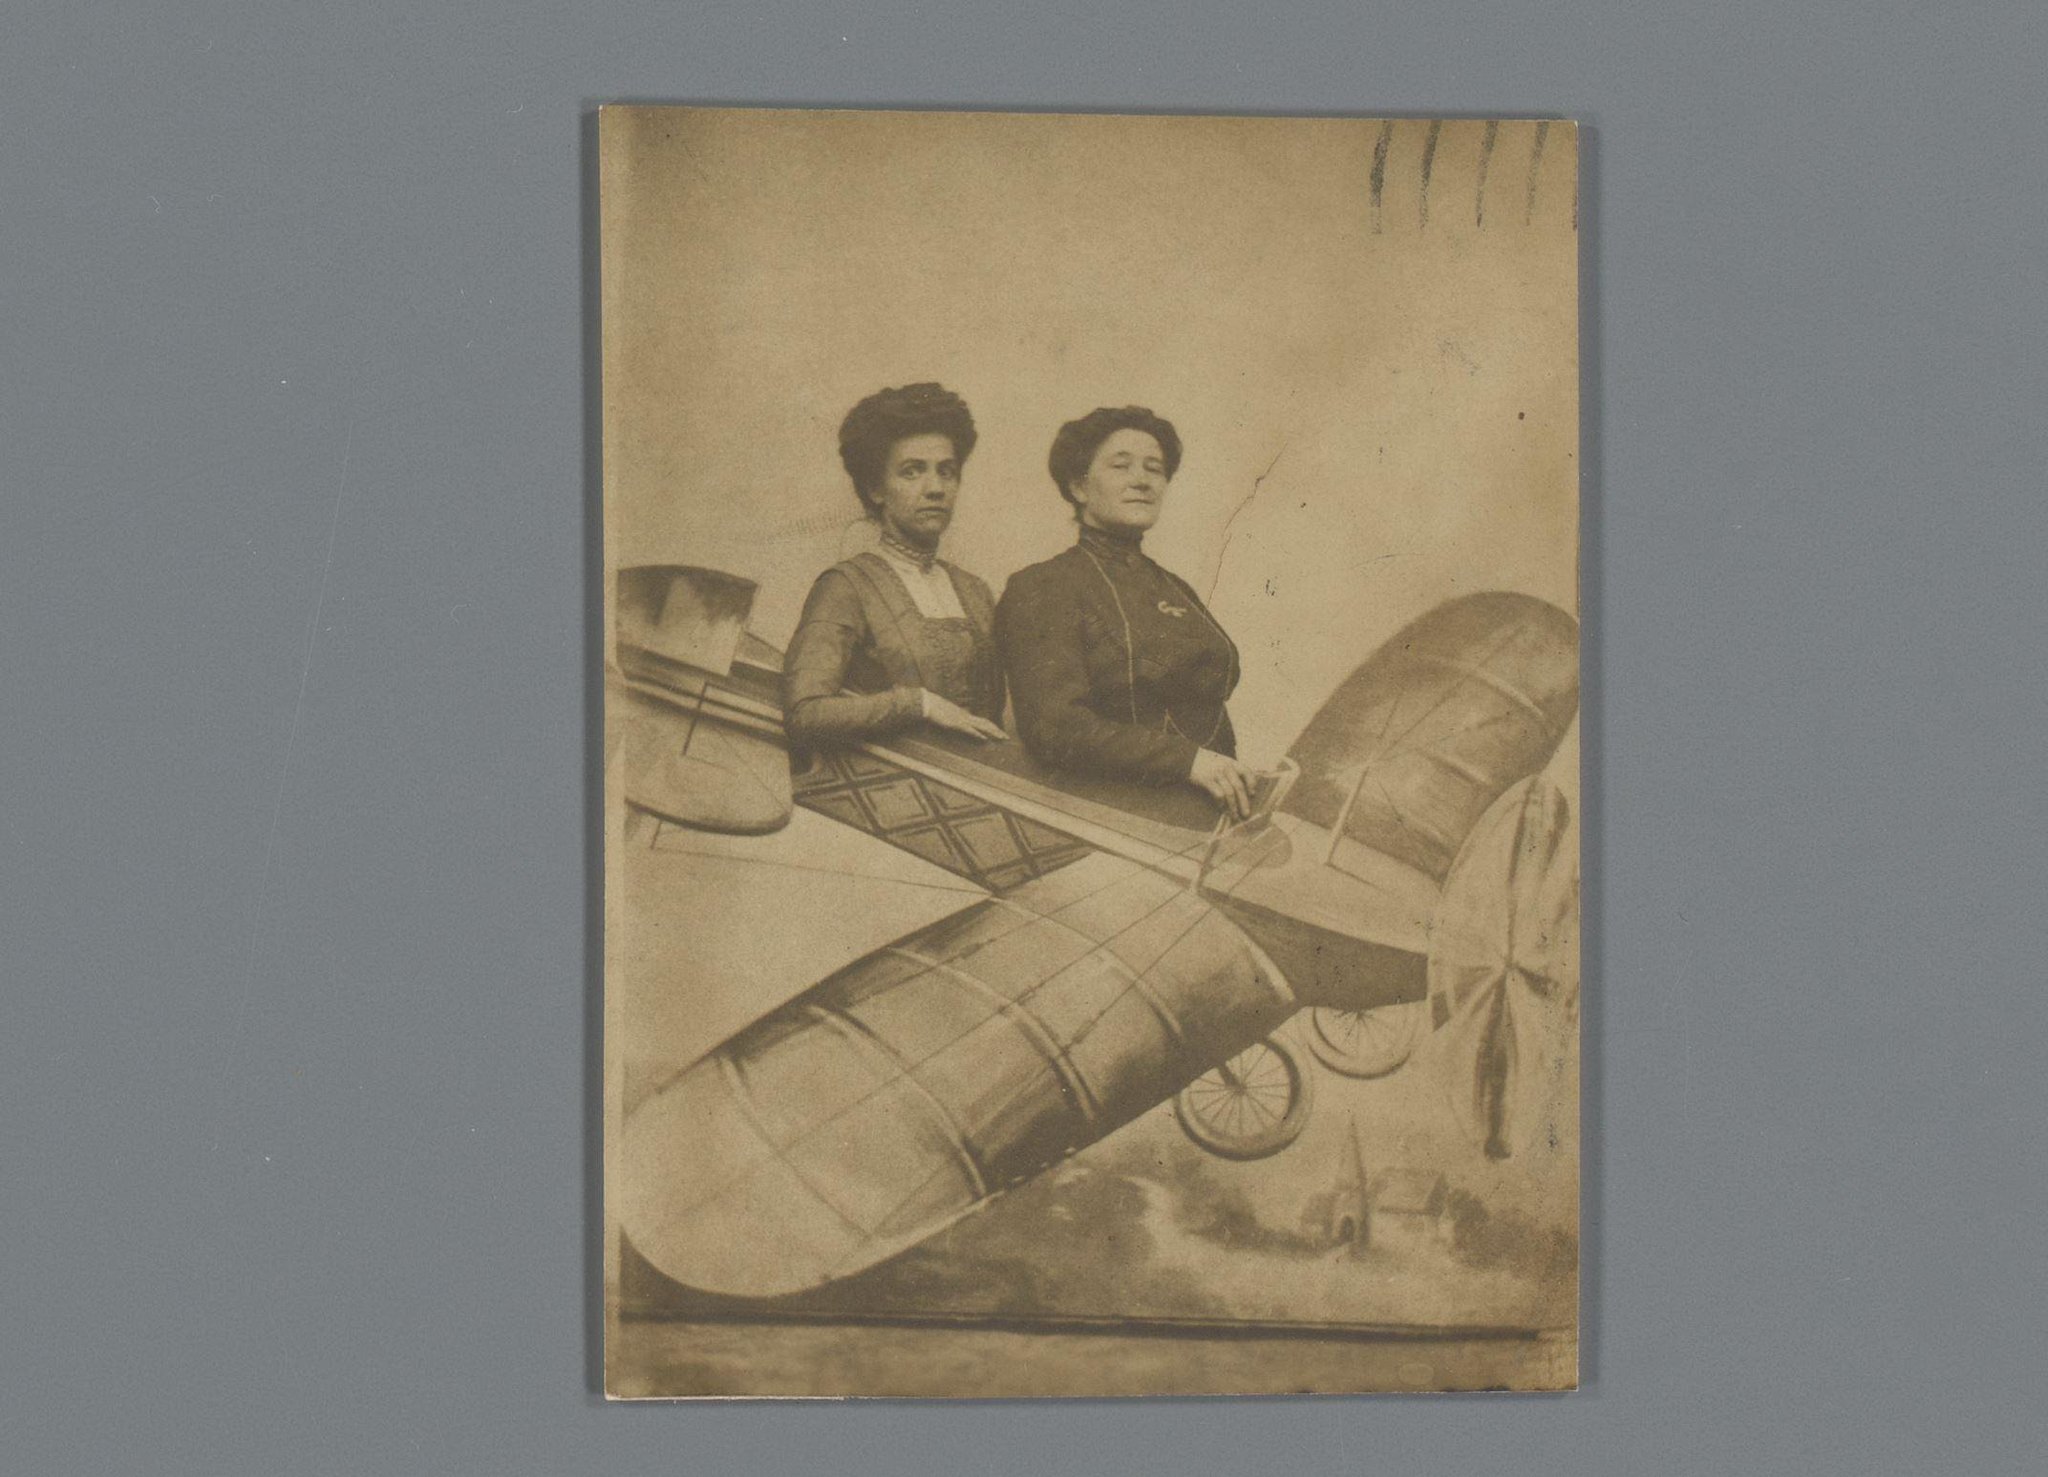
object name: photograph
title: Dubbelportret van twee onbekende vrouwen in een geschilderd decor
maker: Anonymous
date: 1911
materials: paper, cardboard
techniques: gelatin silver print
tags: adult woman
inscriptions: inscription: ‘Madame Chandine/ Rue du Chateau/ Lessi[...]’, inscription: ‘11-12/ 25 IV/ 1911/ LUIK’